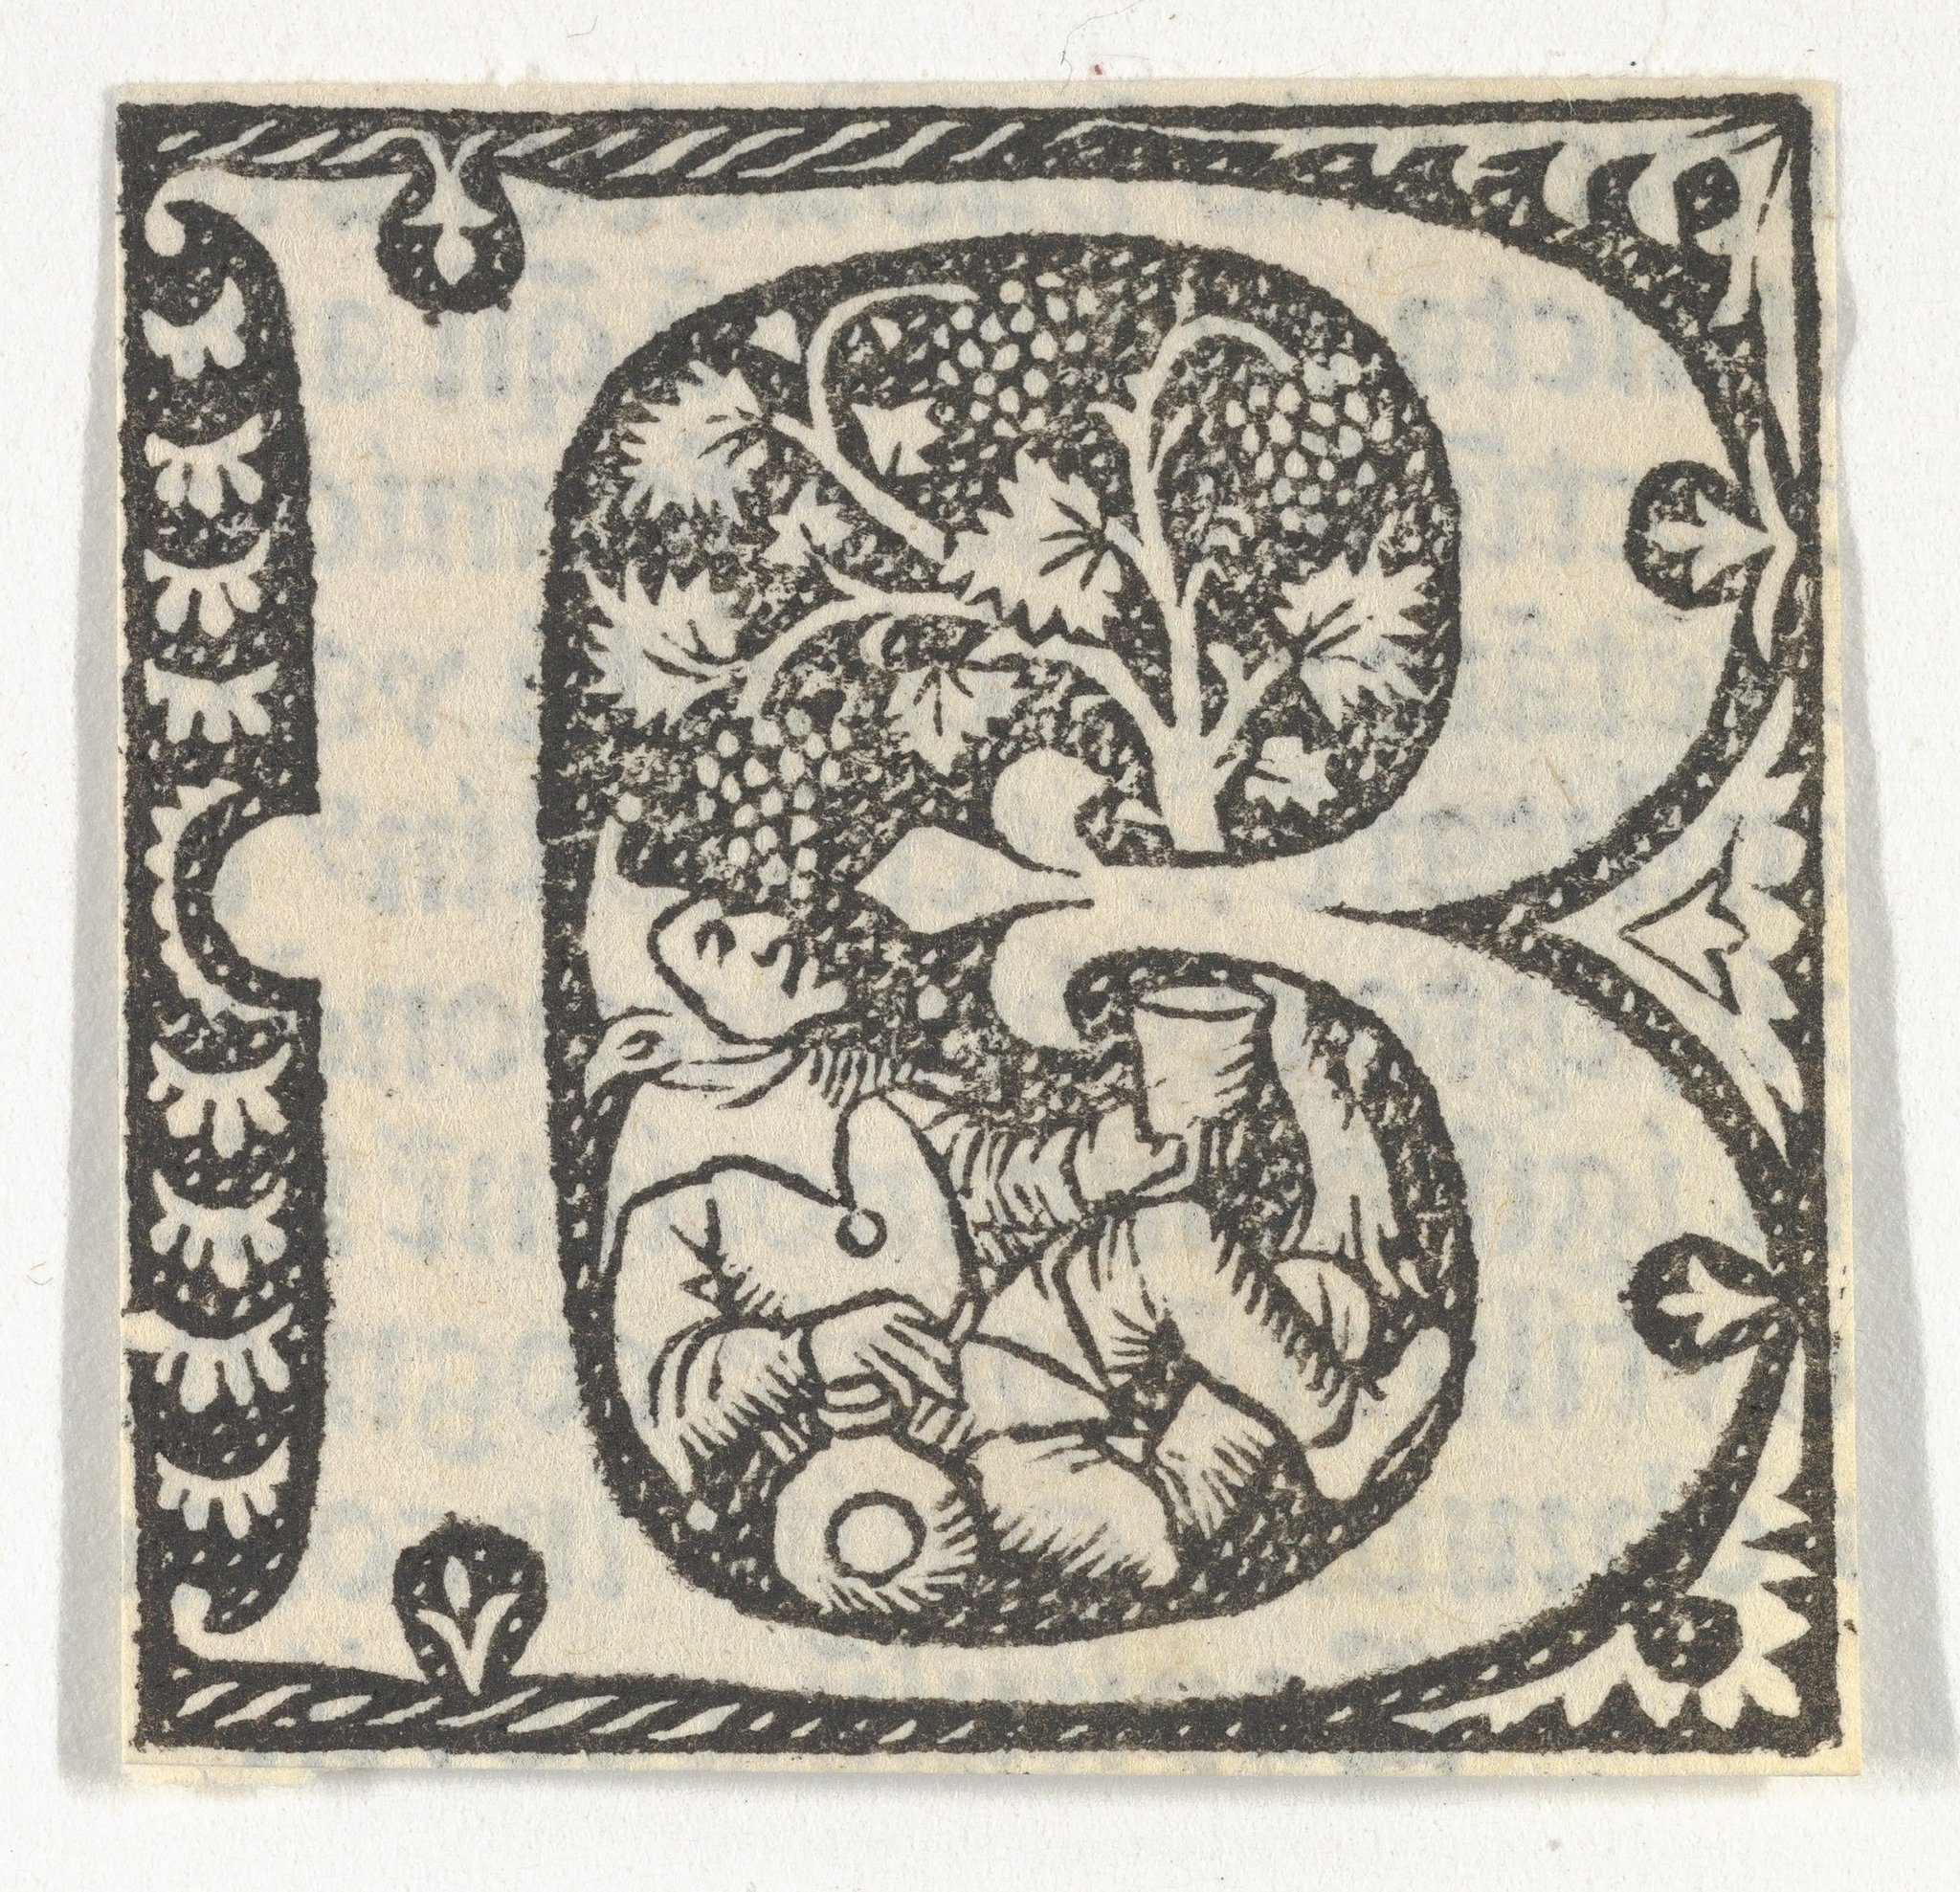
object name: print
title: Decorated Roman alphabet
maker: anonymous, french, 15th century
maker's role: artist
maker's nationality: french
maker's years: 1400-1500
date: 1499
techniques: woodcut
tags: men,trees